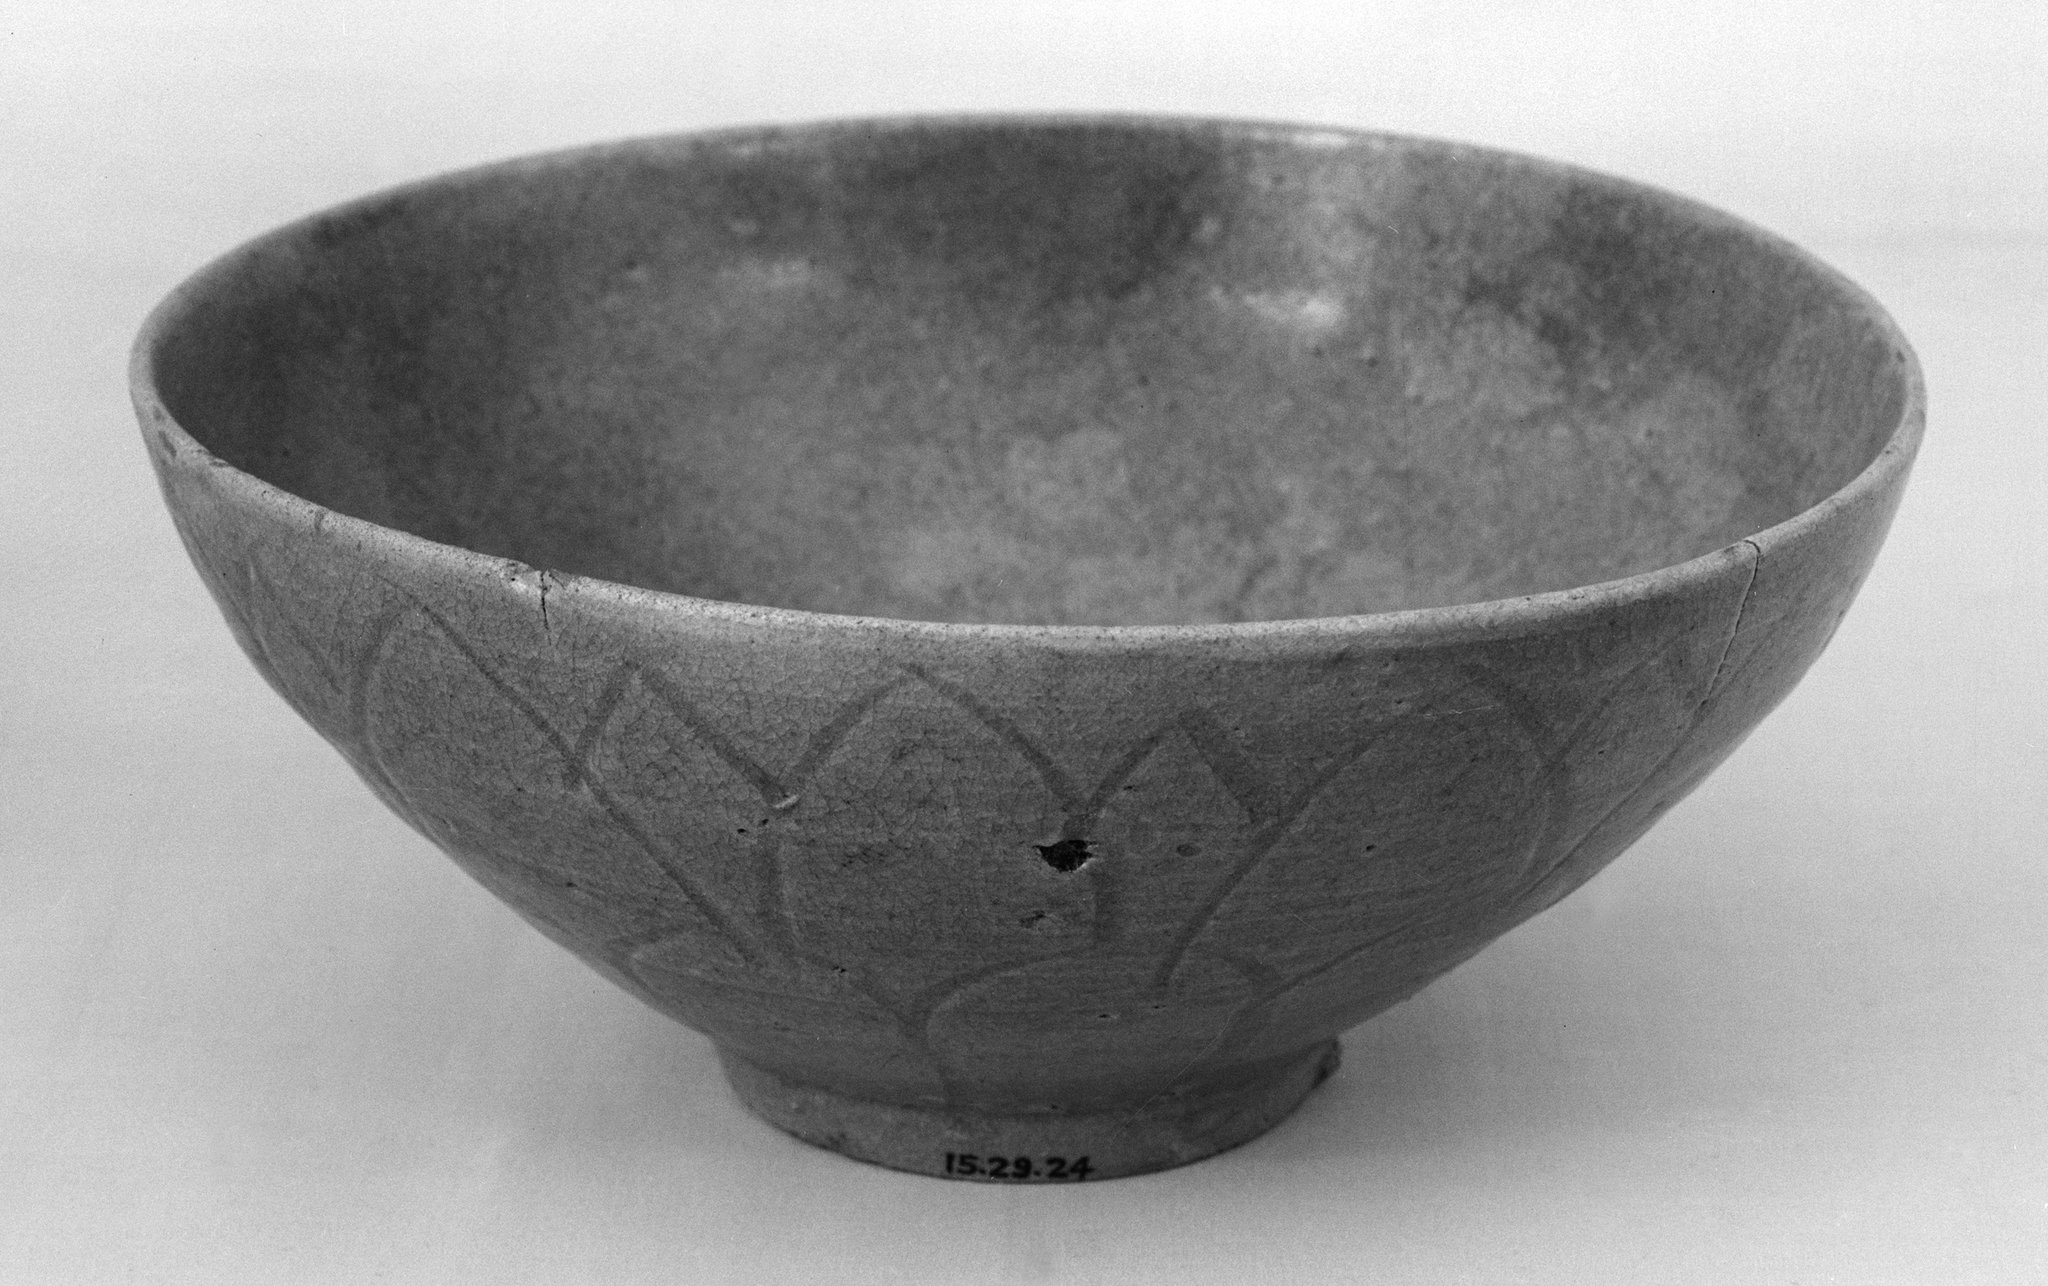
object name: bowl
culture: korean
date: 1001-1133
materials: ceramic glaze, glaze, stoneware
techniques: carving